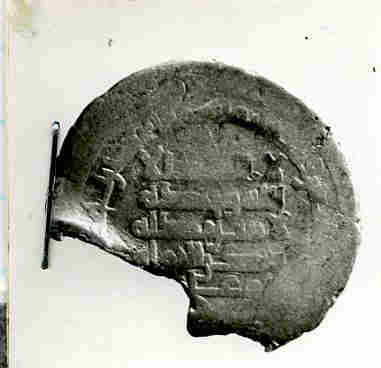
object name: coin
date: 977-982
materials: silver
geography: iran